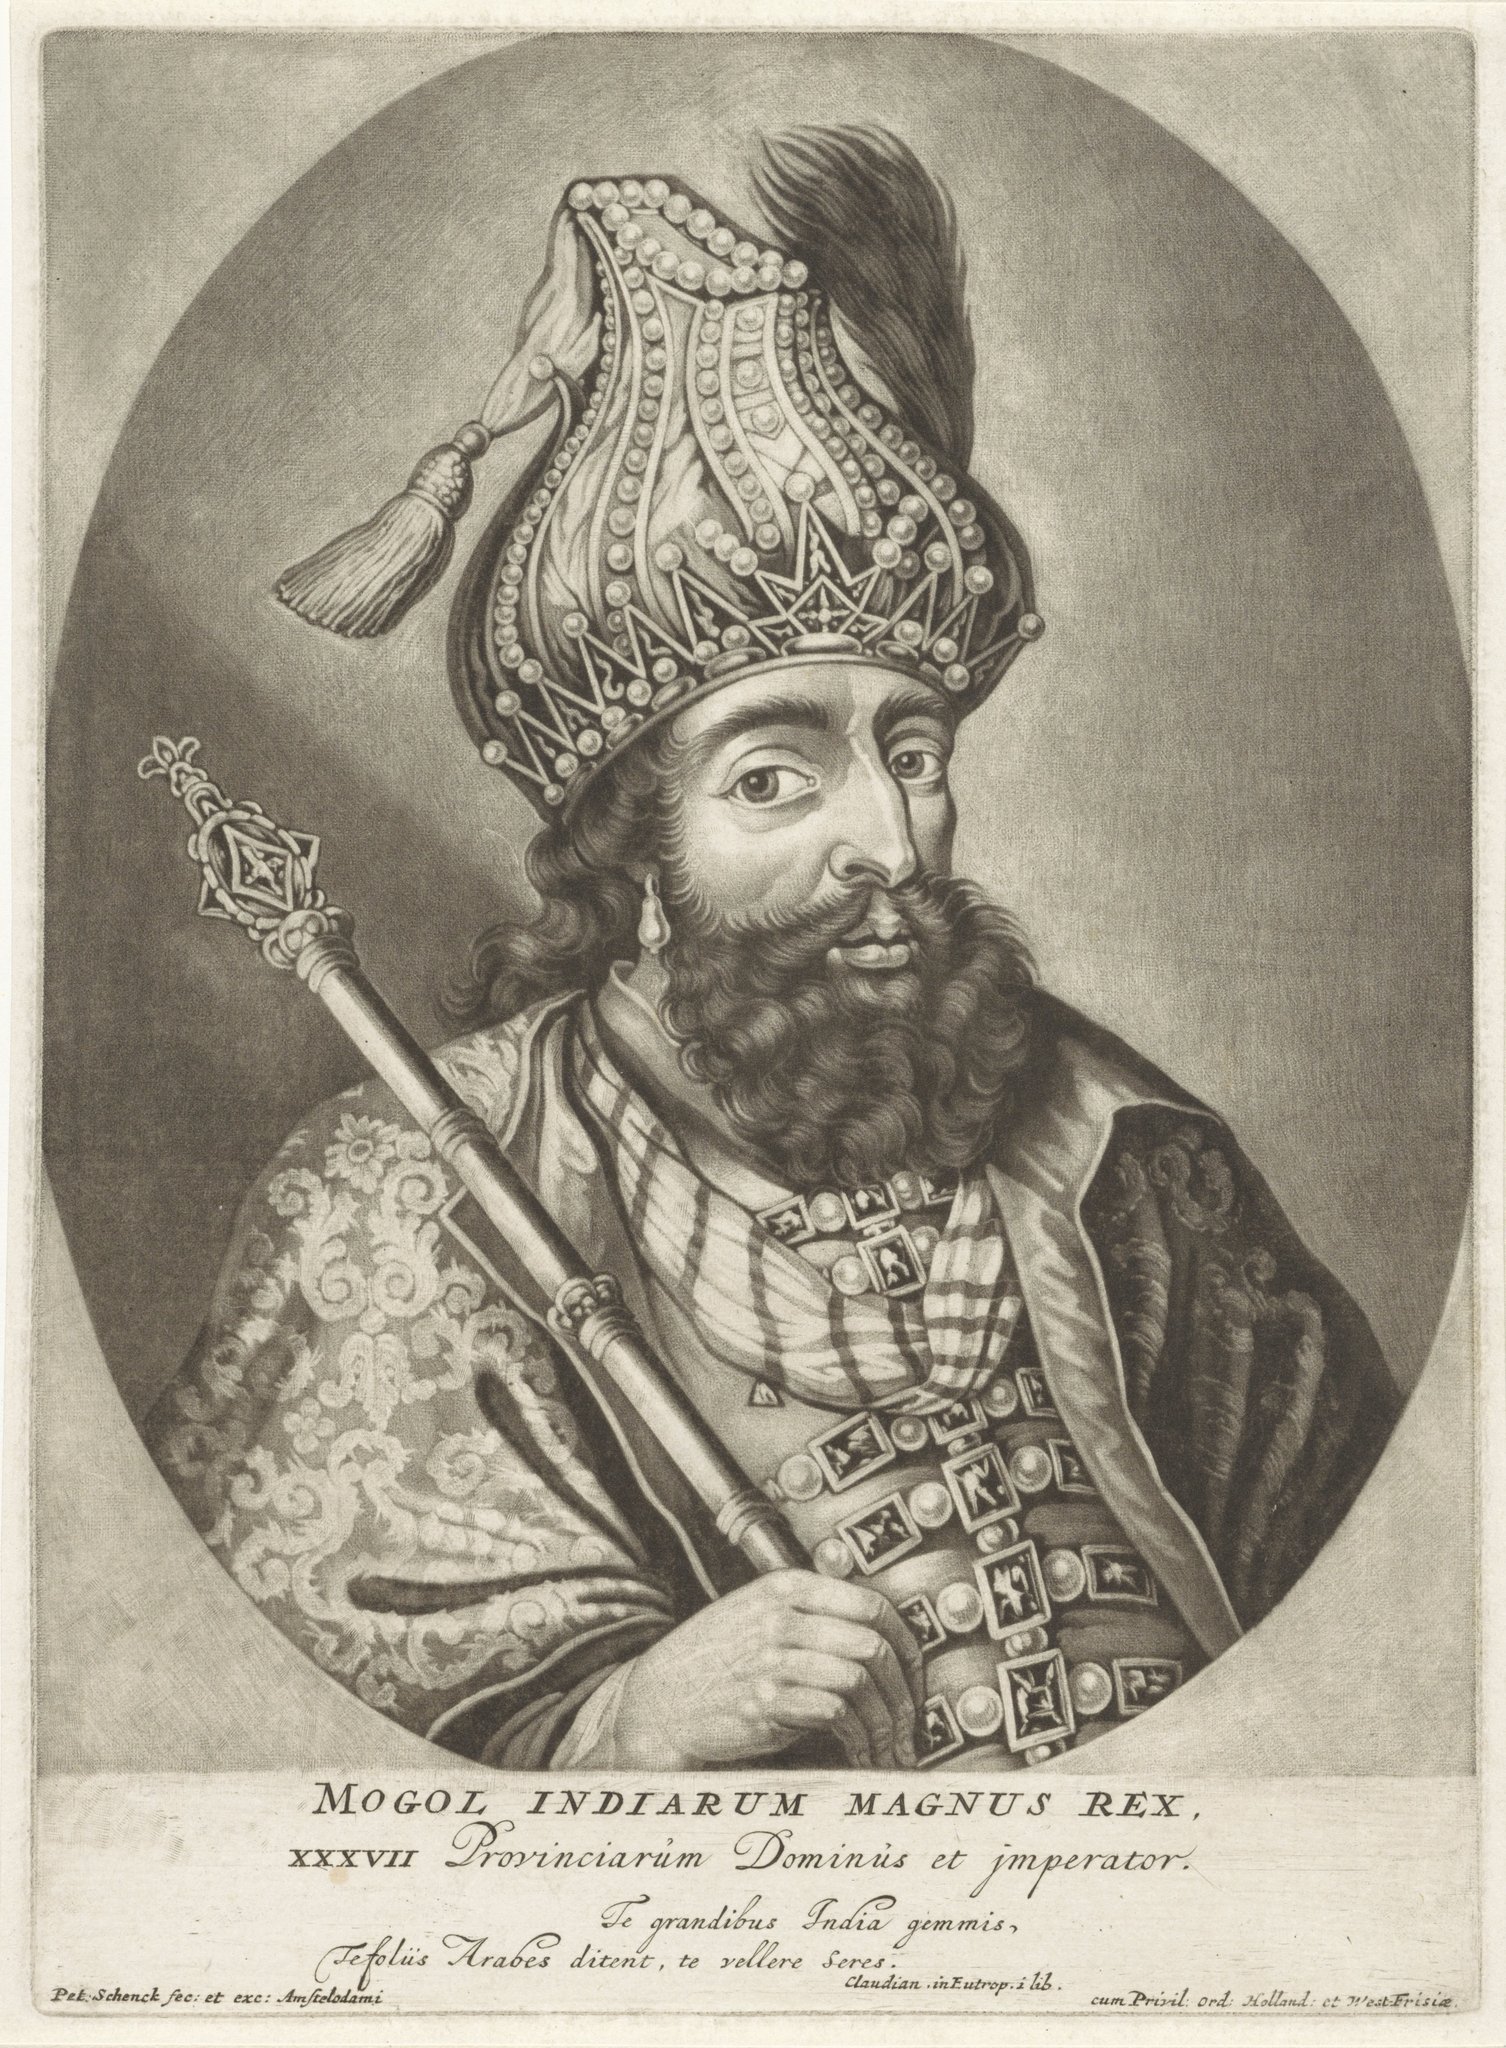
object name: print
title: Portret van een heerser van het Mogoelrijk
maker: pieter schenk (i)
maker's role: print maker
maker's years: 1660-1711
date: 1670-1713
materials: paper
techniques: engraving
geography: amsterdam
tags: insignia and symbols of sovereignty (crown, diadem, sceptre, orb, seal, standard, cloak, pectoral), pearl; pearl necklace (+ women's clothes)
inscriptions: collector's mark: Lugt 2228, collector's mark: Lugt 2028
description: Een soeverein van het Mogoelrijk in India met een hoofdtooi met parels. Hij heeft een scepter in zijn hand.